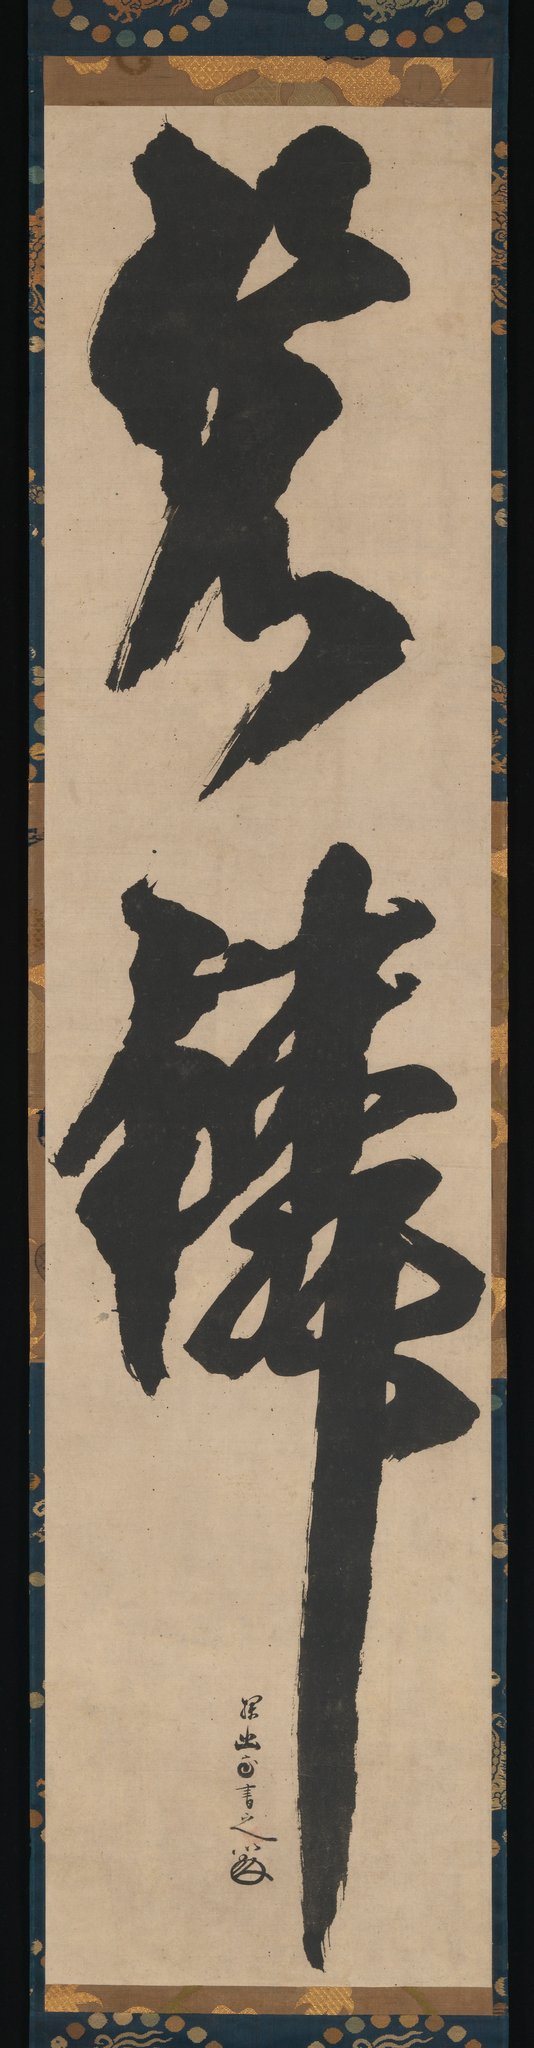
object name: hanging scroll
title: “Bluish-Green Fish Scales”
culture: japanese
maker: kano tan'yū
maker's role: artist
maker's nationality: japanese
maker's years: 1602-1674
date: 1634-1666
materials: ink, paper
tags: japanese